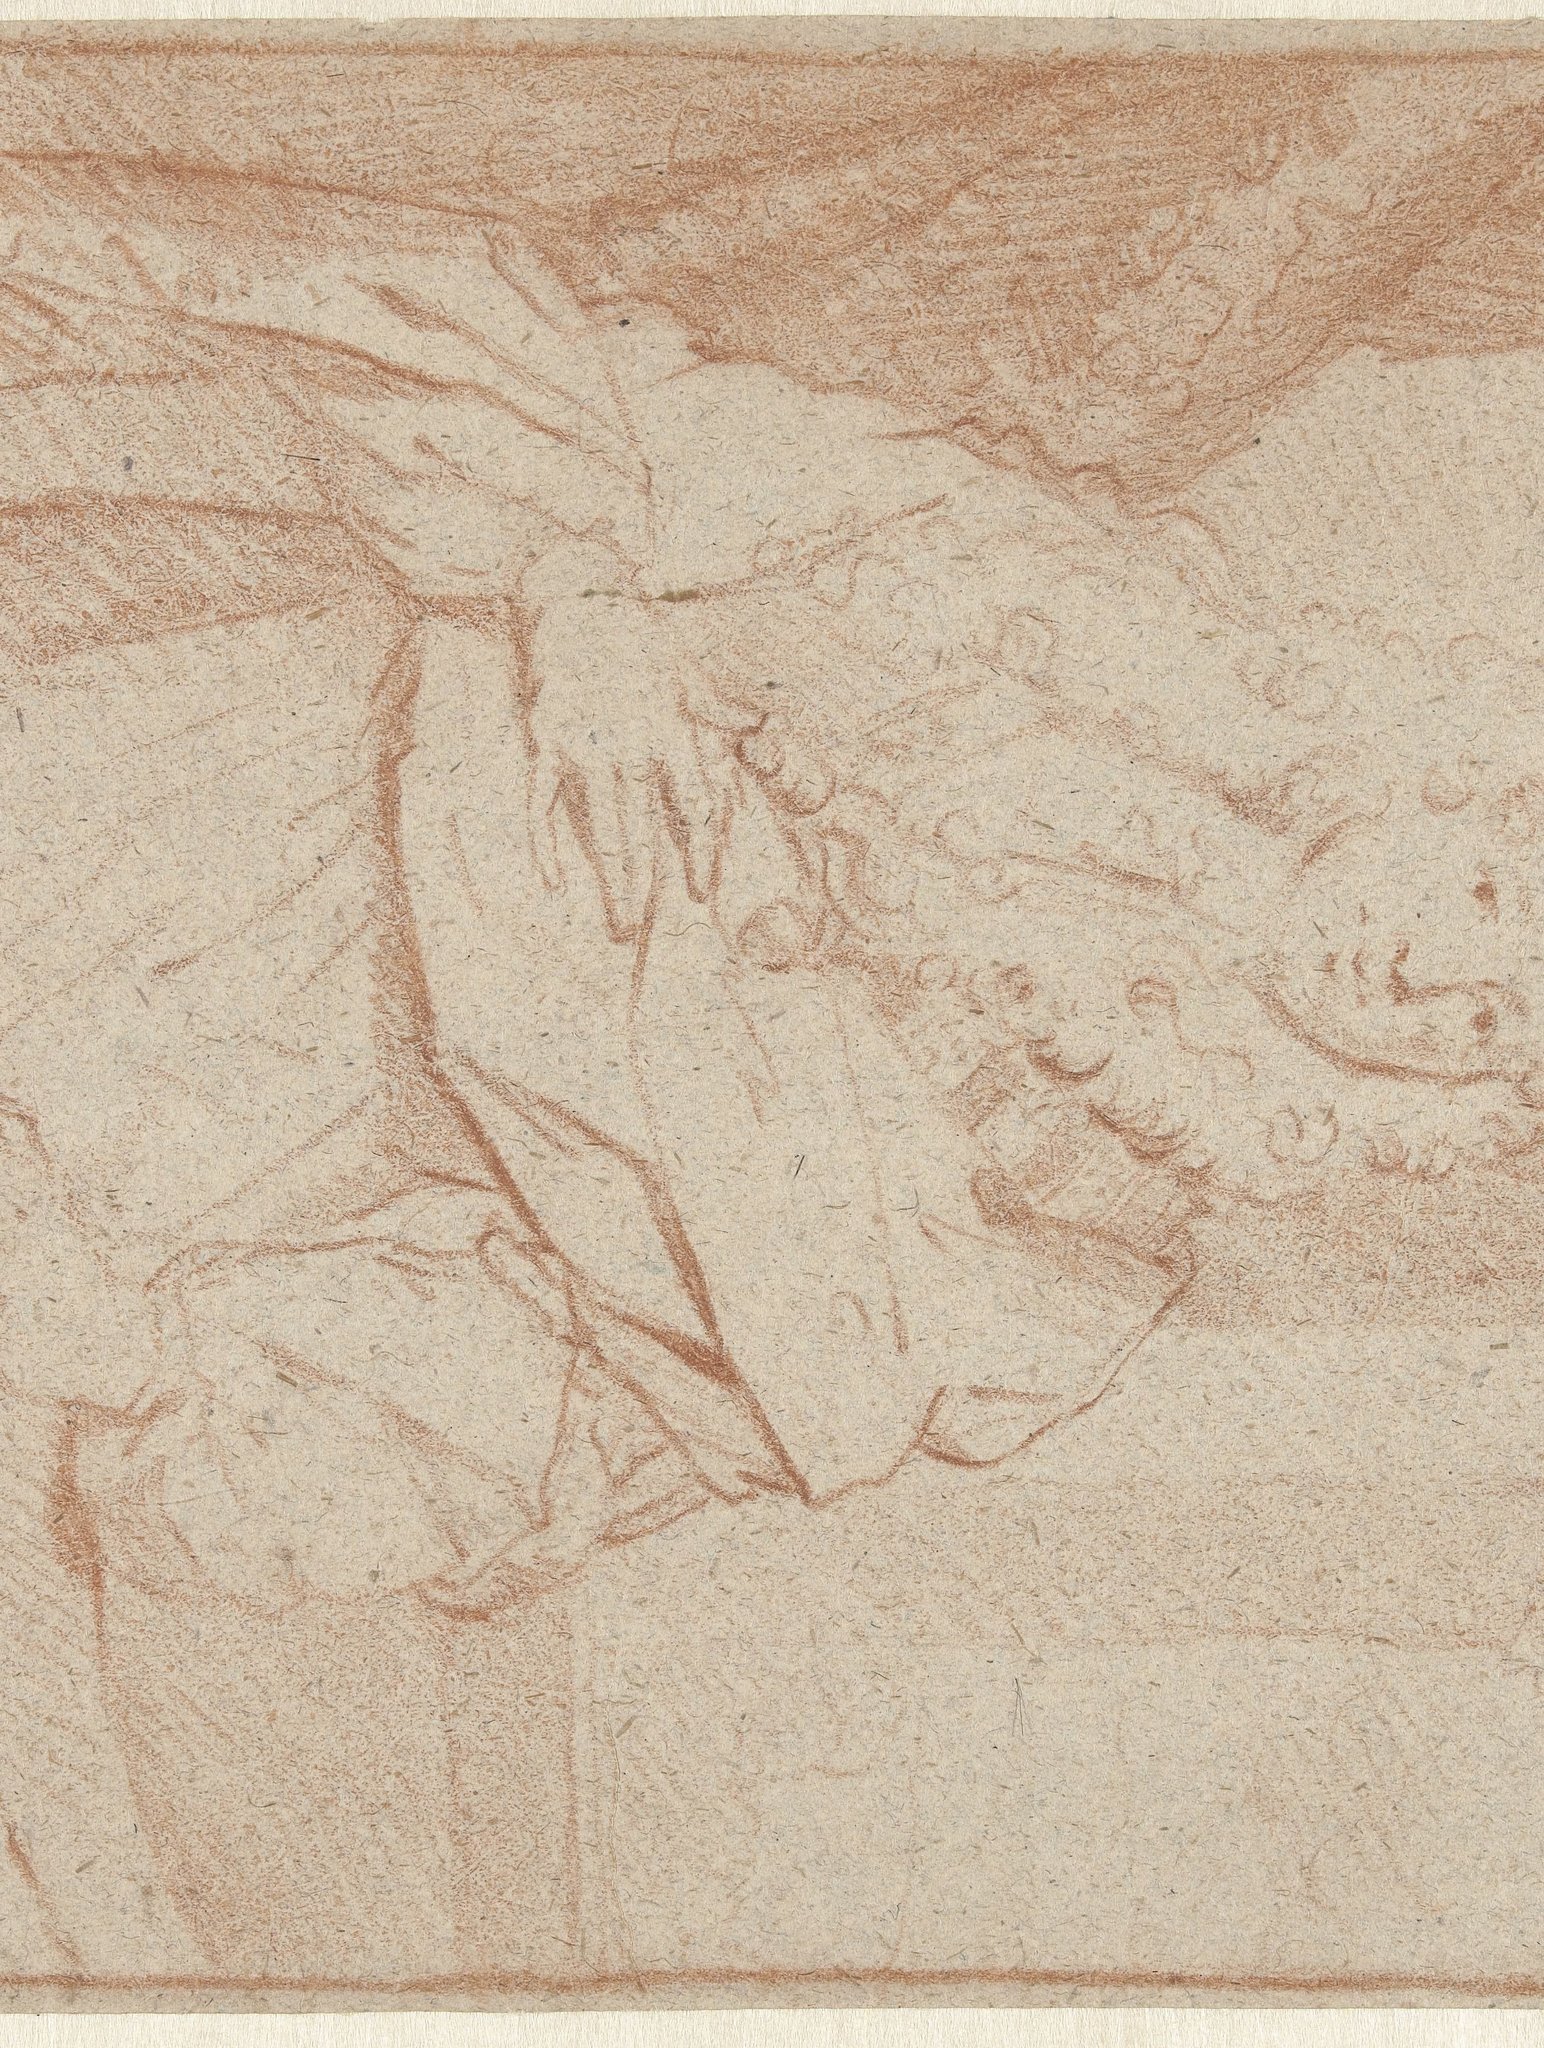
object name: drawing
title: Portret van een staande onbekende man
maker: godfried schalcken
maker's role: draughtsman, painter, print maker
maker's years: 1643-1706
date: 1653-1706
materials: chalk, paper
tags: standing figure, anonymous historical person portrayed alone